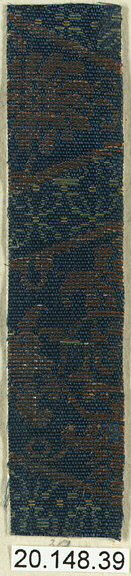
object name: piece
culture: japanese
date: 1401-1500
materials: silk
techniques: compound weave